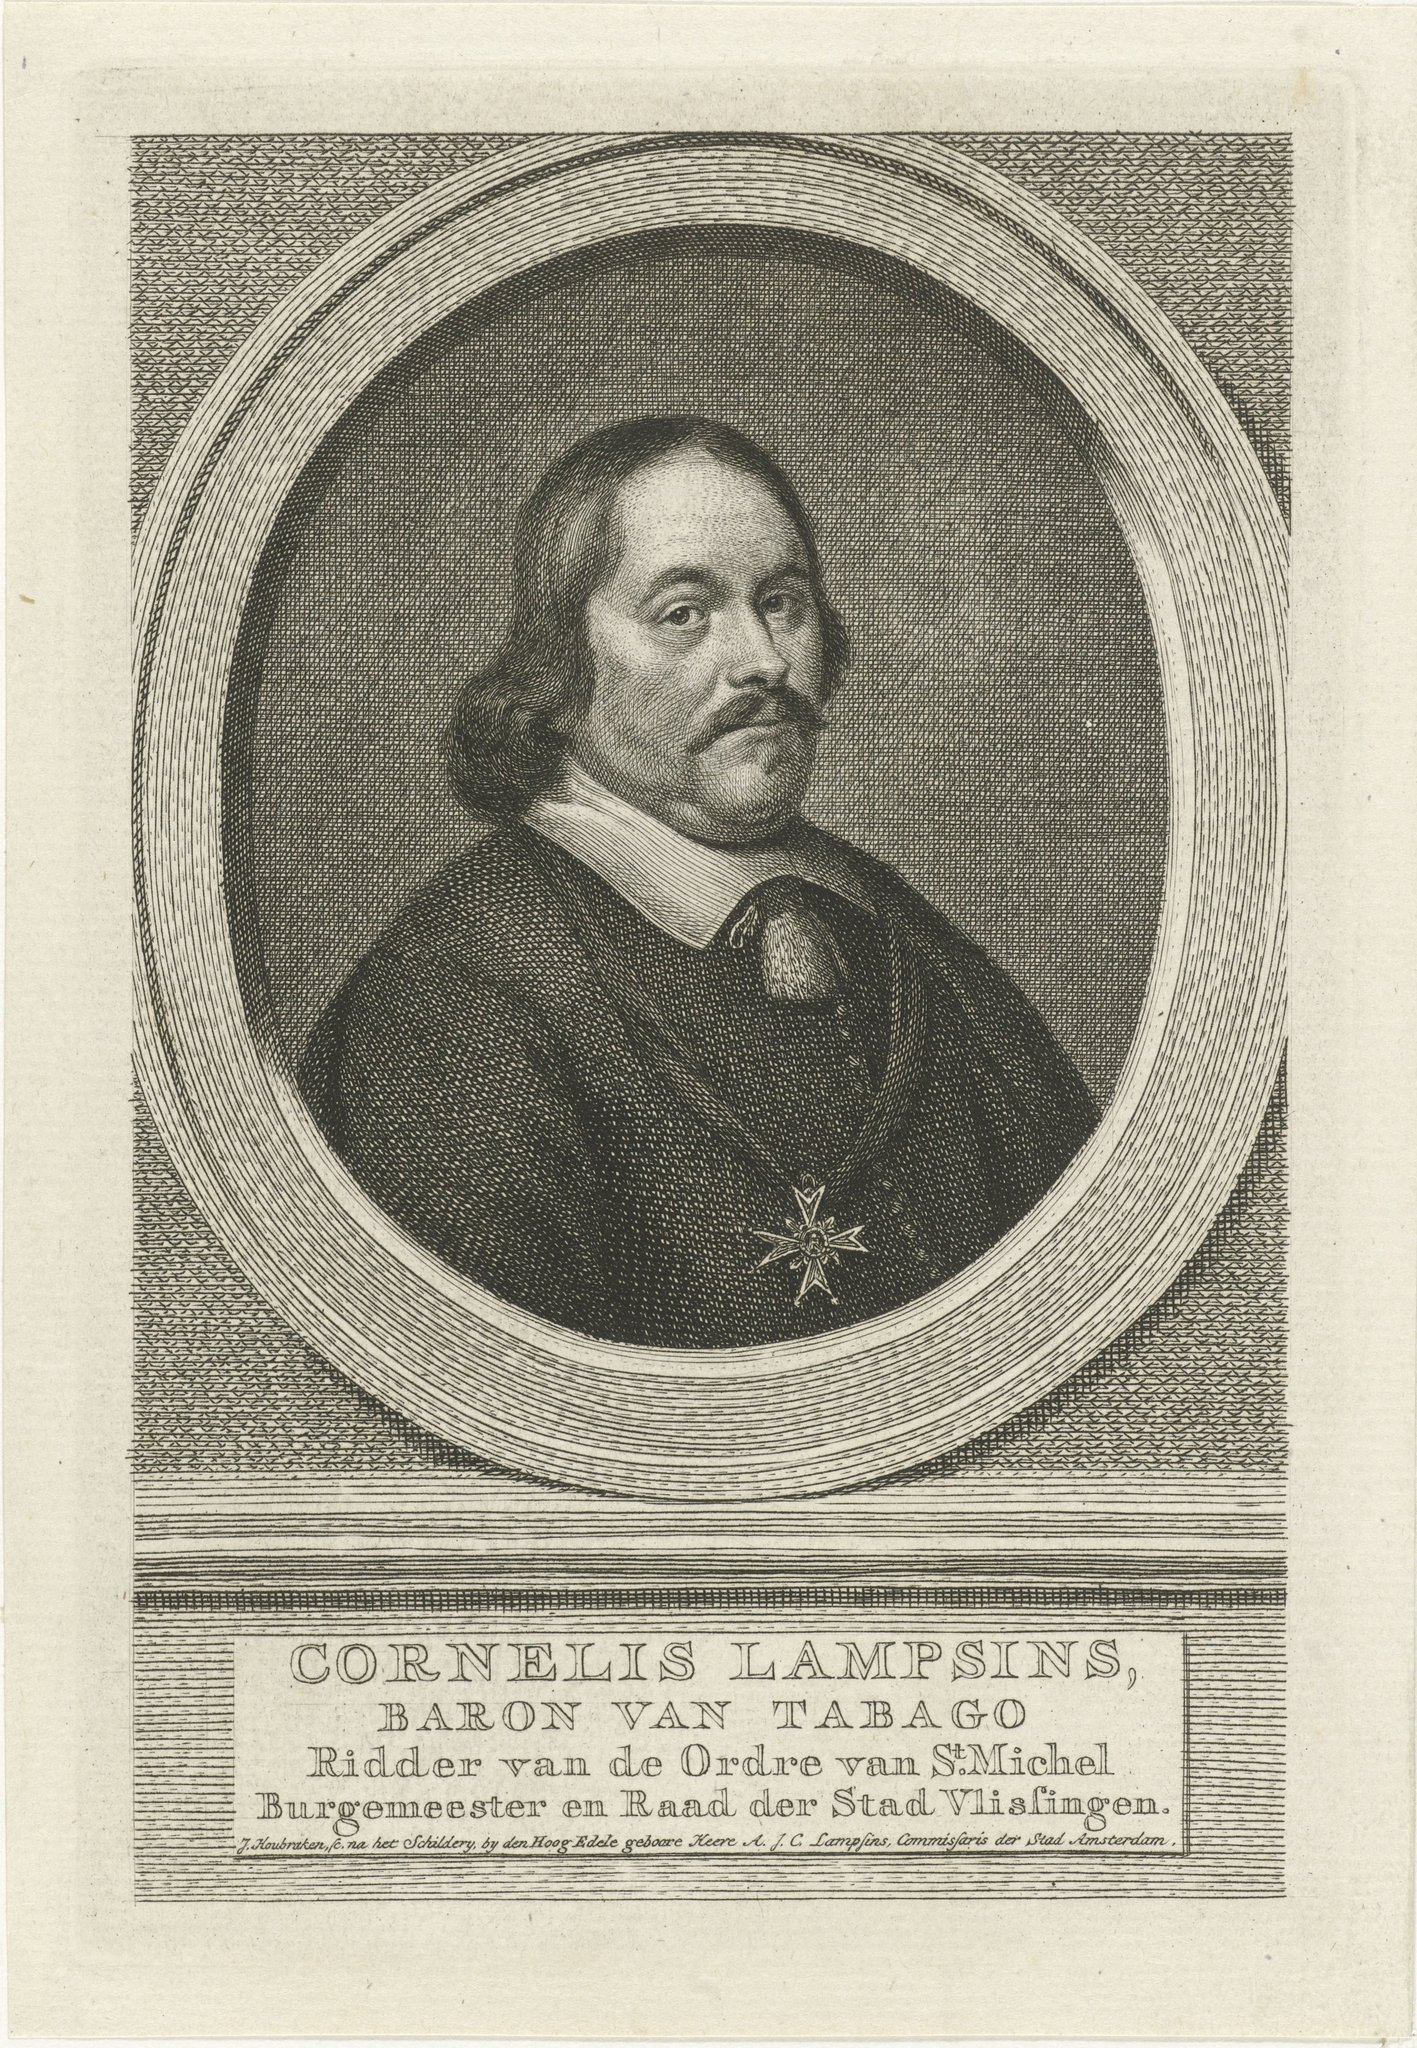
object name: print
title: Portret van Cornelis Lampsins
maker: jacob houbraken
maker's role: draughtsman, print maker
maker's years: 1698-1780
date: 1749-1780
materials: paper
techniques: engraving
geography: amsterdam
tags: knighthood order, historical persons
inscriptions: collector's mark: Lugt 2228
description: Deze prent is oorspronkelijk bedoeld als aanvulling op Jan Wagenaars ‘Vaderlandsche historie’* en was zo vanaf 1796 verkrijgbaar bij Johannes Allart te Amsterdam. Voor de advertentie waarin Allart de 60 portretten en 7 platen, allen gegraveerd door Houbraken, ter aanvulling op Wagenaars ‘Vaderlandsche historie’ aanbiedt, zie RP-P-OB-77.766. *Van dit werk zijn in de achttiende eeuw meerdere uitgaves verschenen, zoals: Wagenaar, Jan. Vaderlandsche historie, vervattende de geschiedenissen der Vereenigde Nederlanden (…). 21 delen. Amsterdam: Isaak Tirion, 1749-1759. Wagenaar, Jan. Vaderlandsche historie, vervattende de geschiedenissen der nu Vereenigde Nederlanden (…). 21 delen. Amsterdam: weduwe Isaak Tirion, 1770. Wagenaar, Jan. Vaderlandsche historie, vervattende de geschiedenissen der nu Vereenigde Nederlanden (…). 21 delen. Amsterdam, Leiden, Dordrecht en Harlingen: P. Schouten e.a., 1782. Wagenaar, Jan. Vaderlandsche historie, vervattende de geschiedenissen der nu Vereenigde Nederlanden (…). 21 delen. Amsterdam: Johannes Allart, 1790-1796.